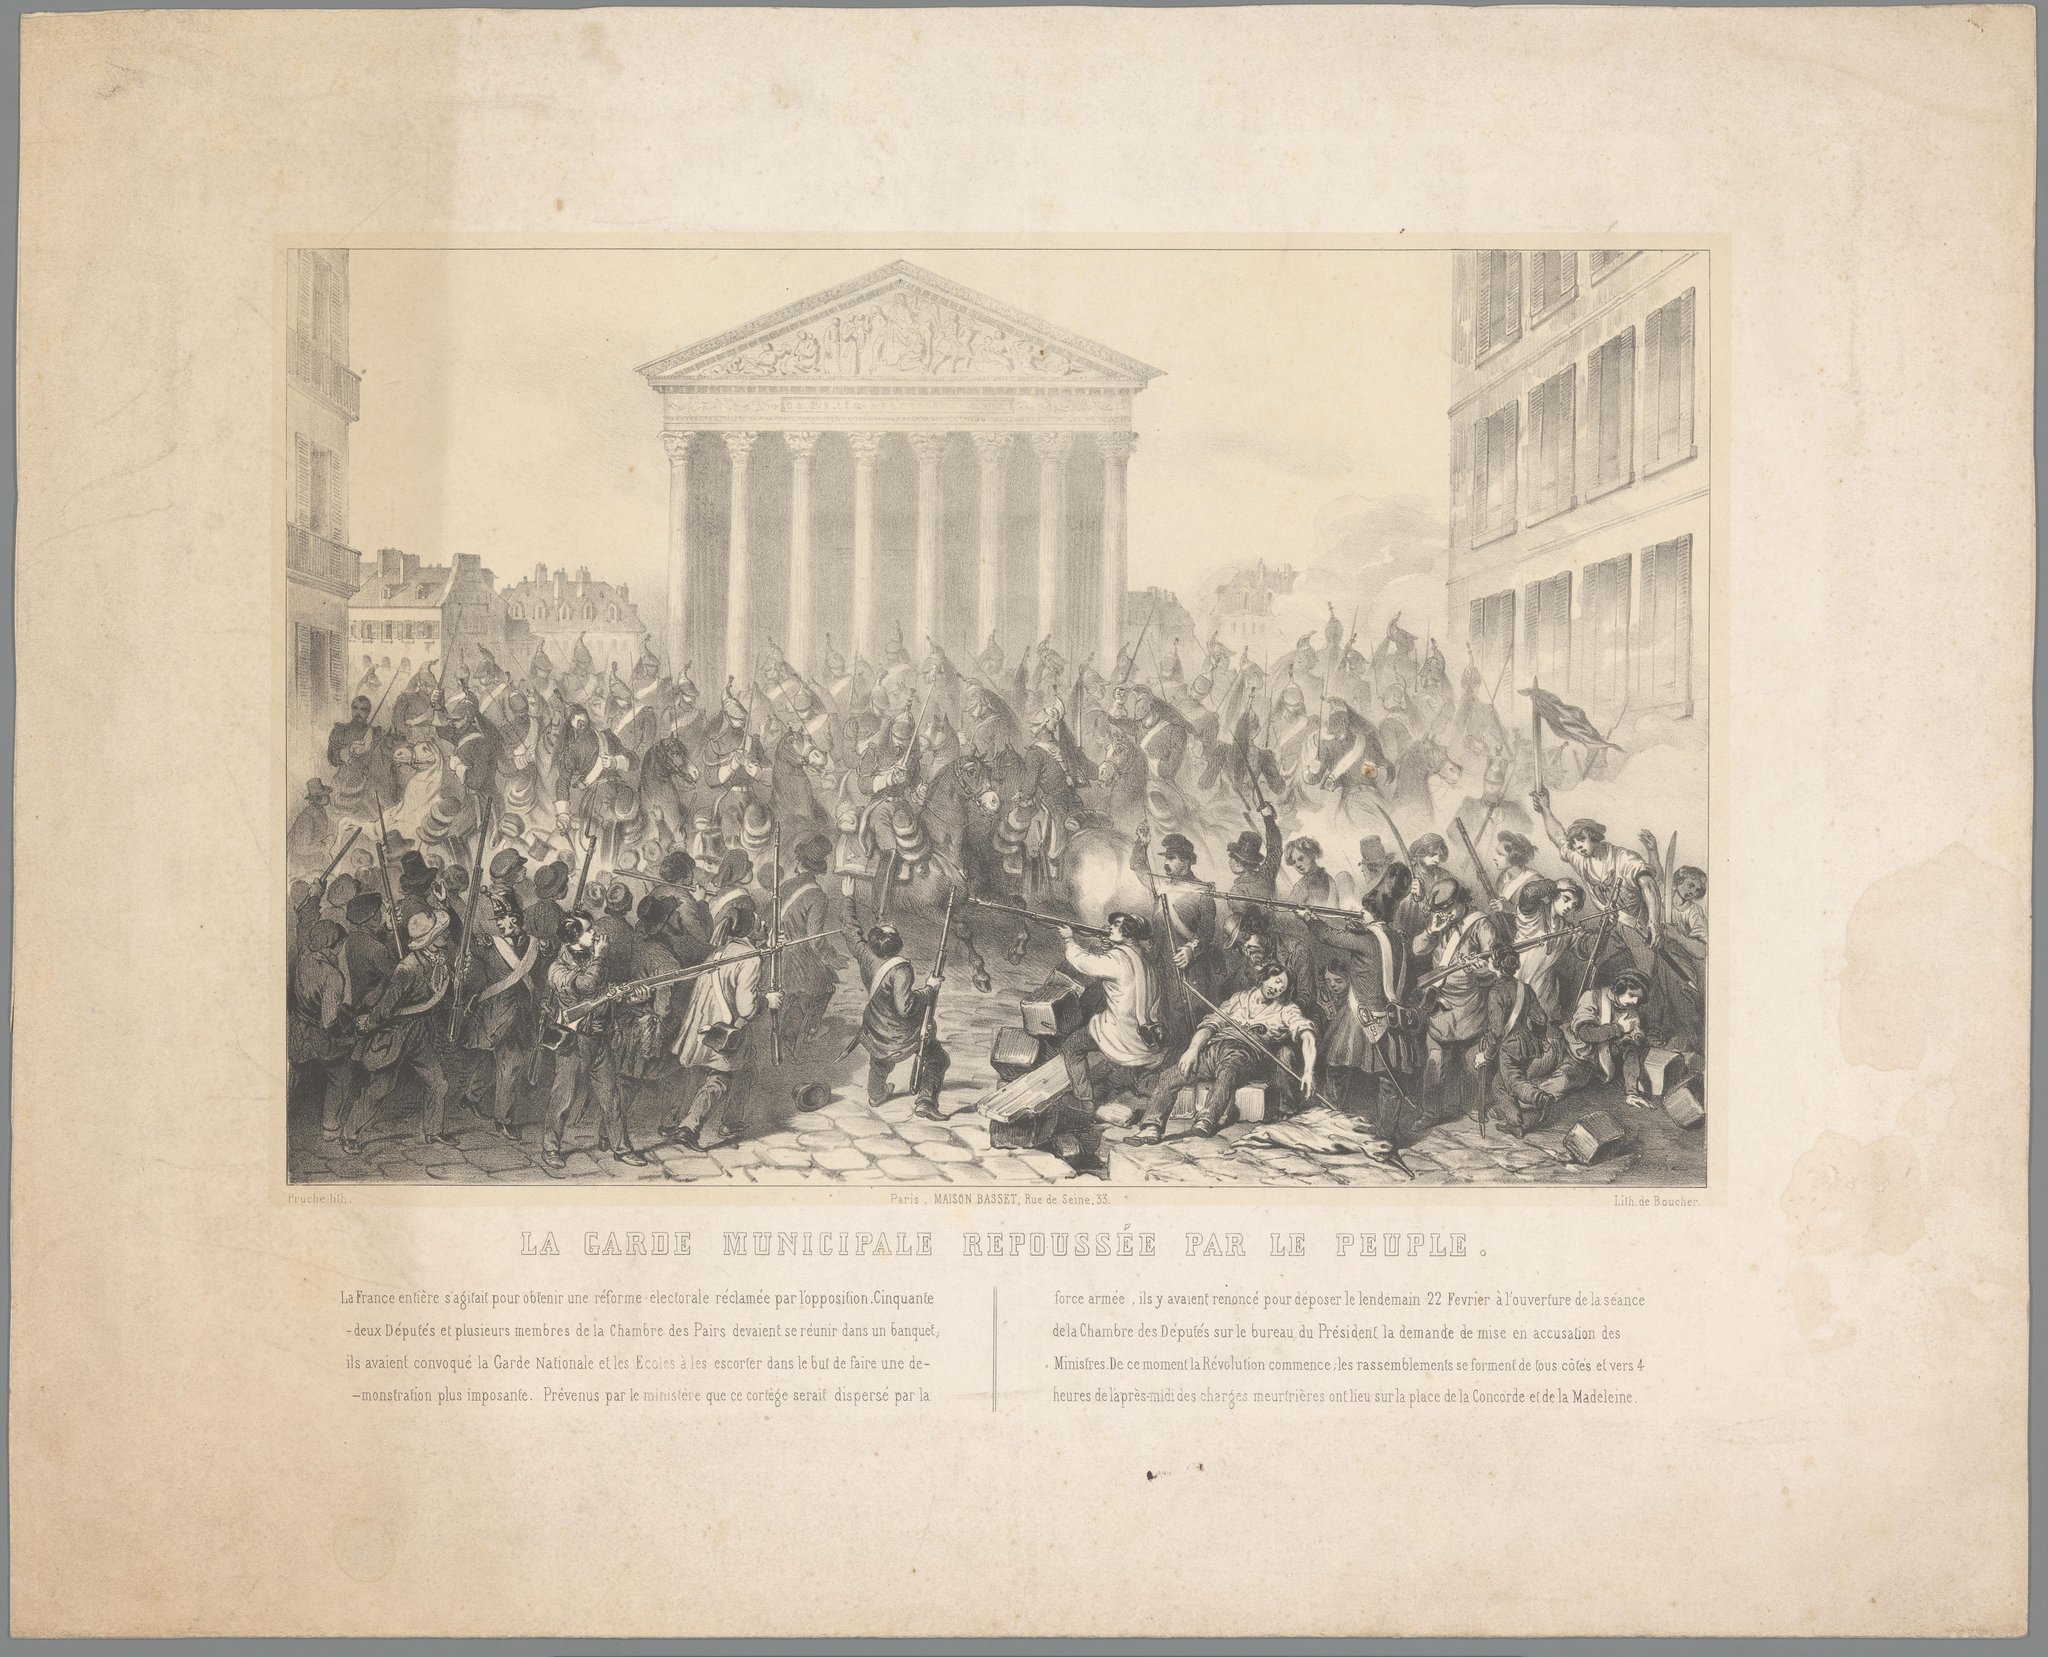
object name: print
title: Gebeurtenissen rond de Februarirevolutie van 1848 te Parijs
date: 1848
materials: paper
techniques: tone lithography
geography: paris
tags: revolution, revolt, paris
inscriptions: collector's mark: Lugt 2228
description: Onderschrift: La France entière s'agitait pour obtenir (...).